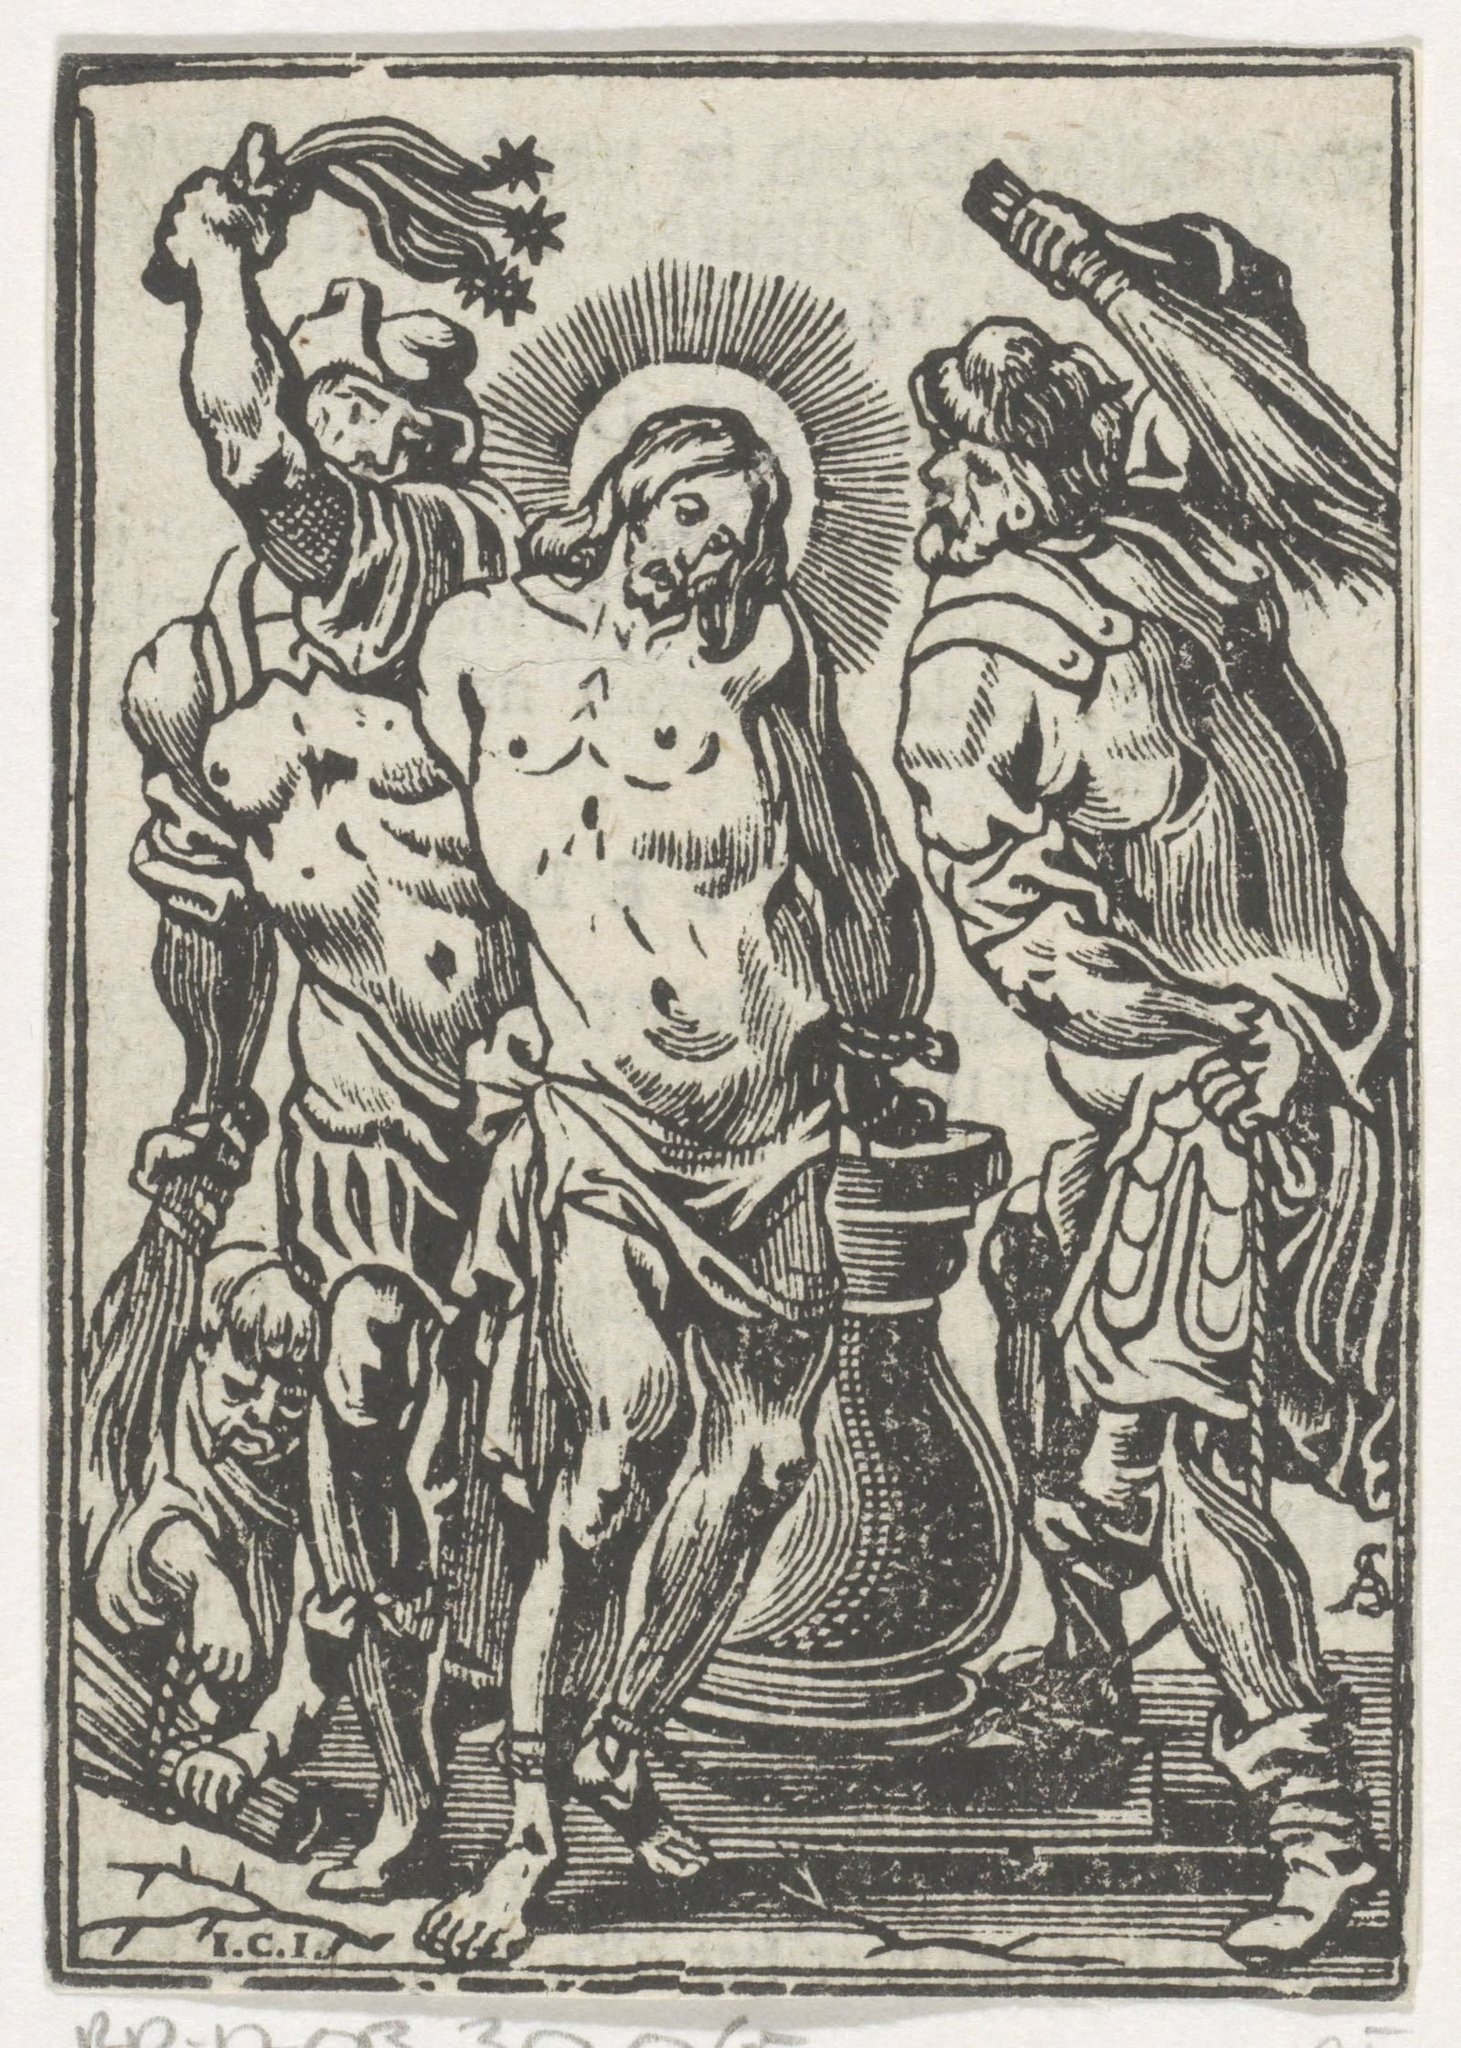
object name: book illustration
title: Geseling van Christus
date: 1649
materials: paper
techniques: letterpress printing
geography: antwerp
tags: flagellation by soldiers, christ usually tied to a column (matthew 27:26; mark 15:15; john 19:1)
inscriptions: collector's mark: Lugt 2228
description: Prent uit: Andries, Judocus. Perpetua crux sive passio Jesu Christi. Antwerpen: Cornelis Woons, 1649.